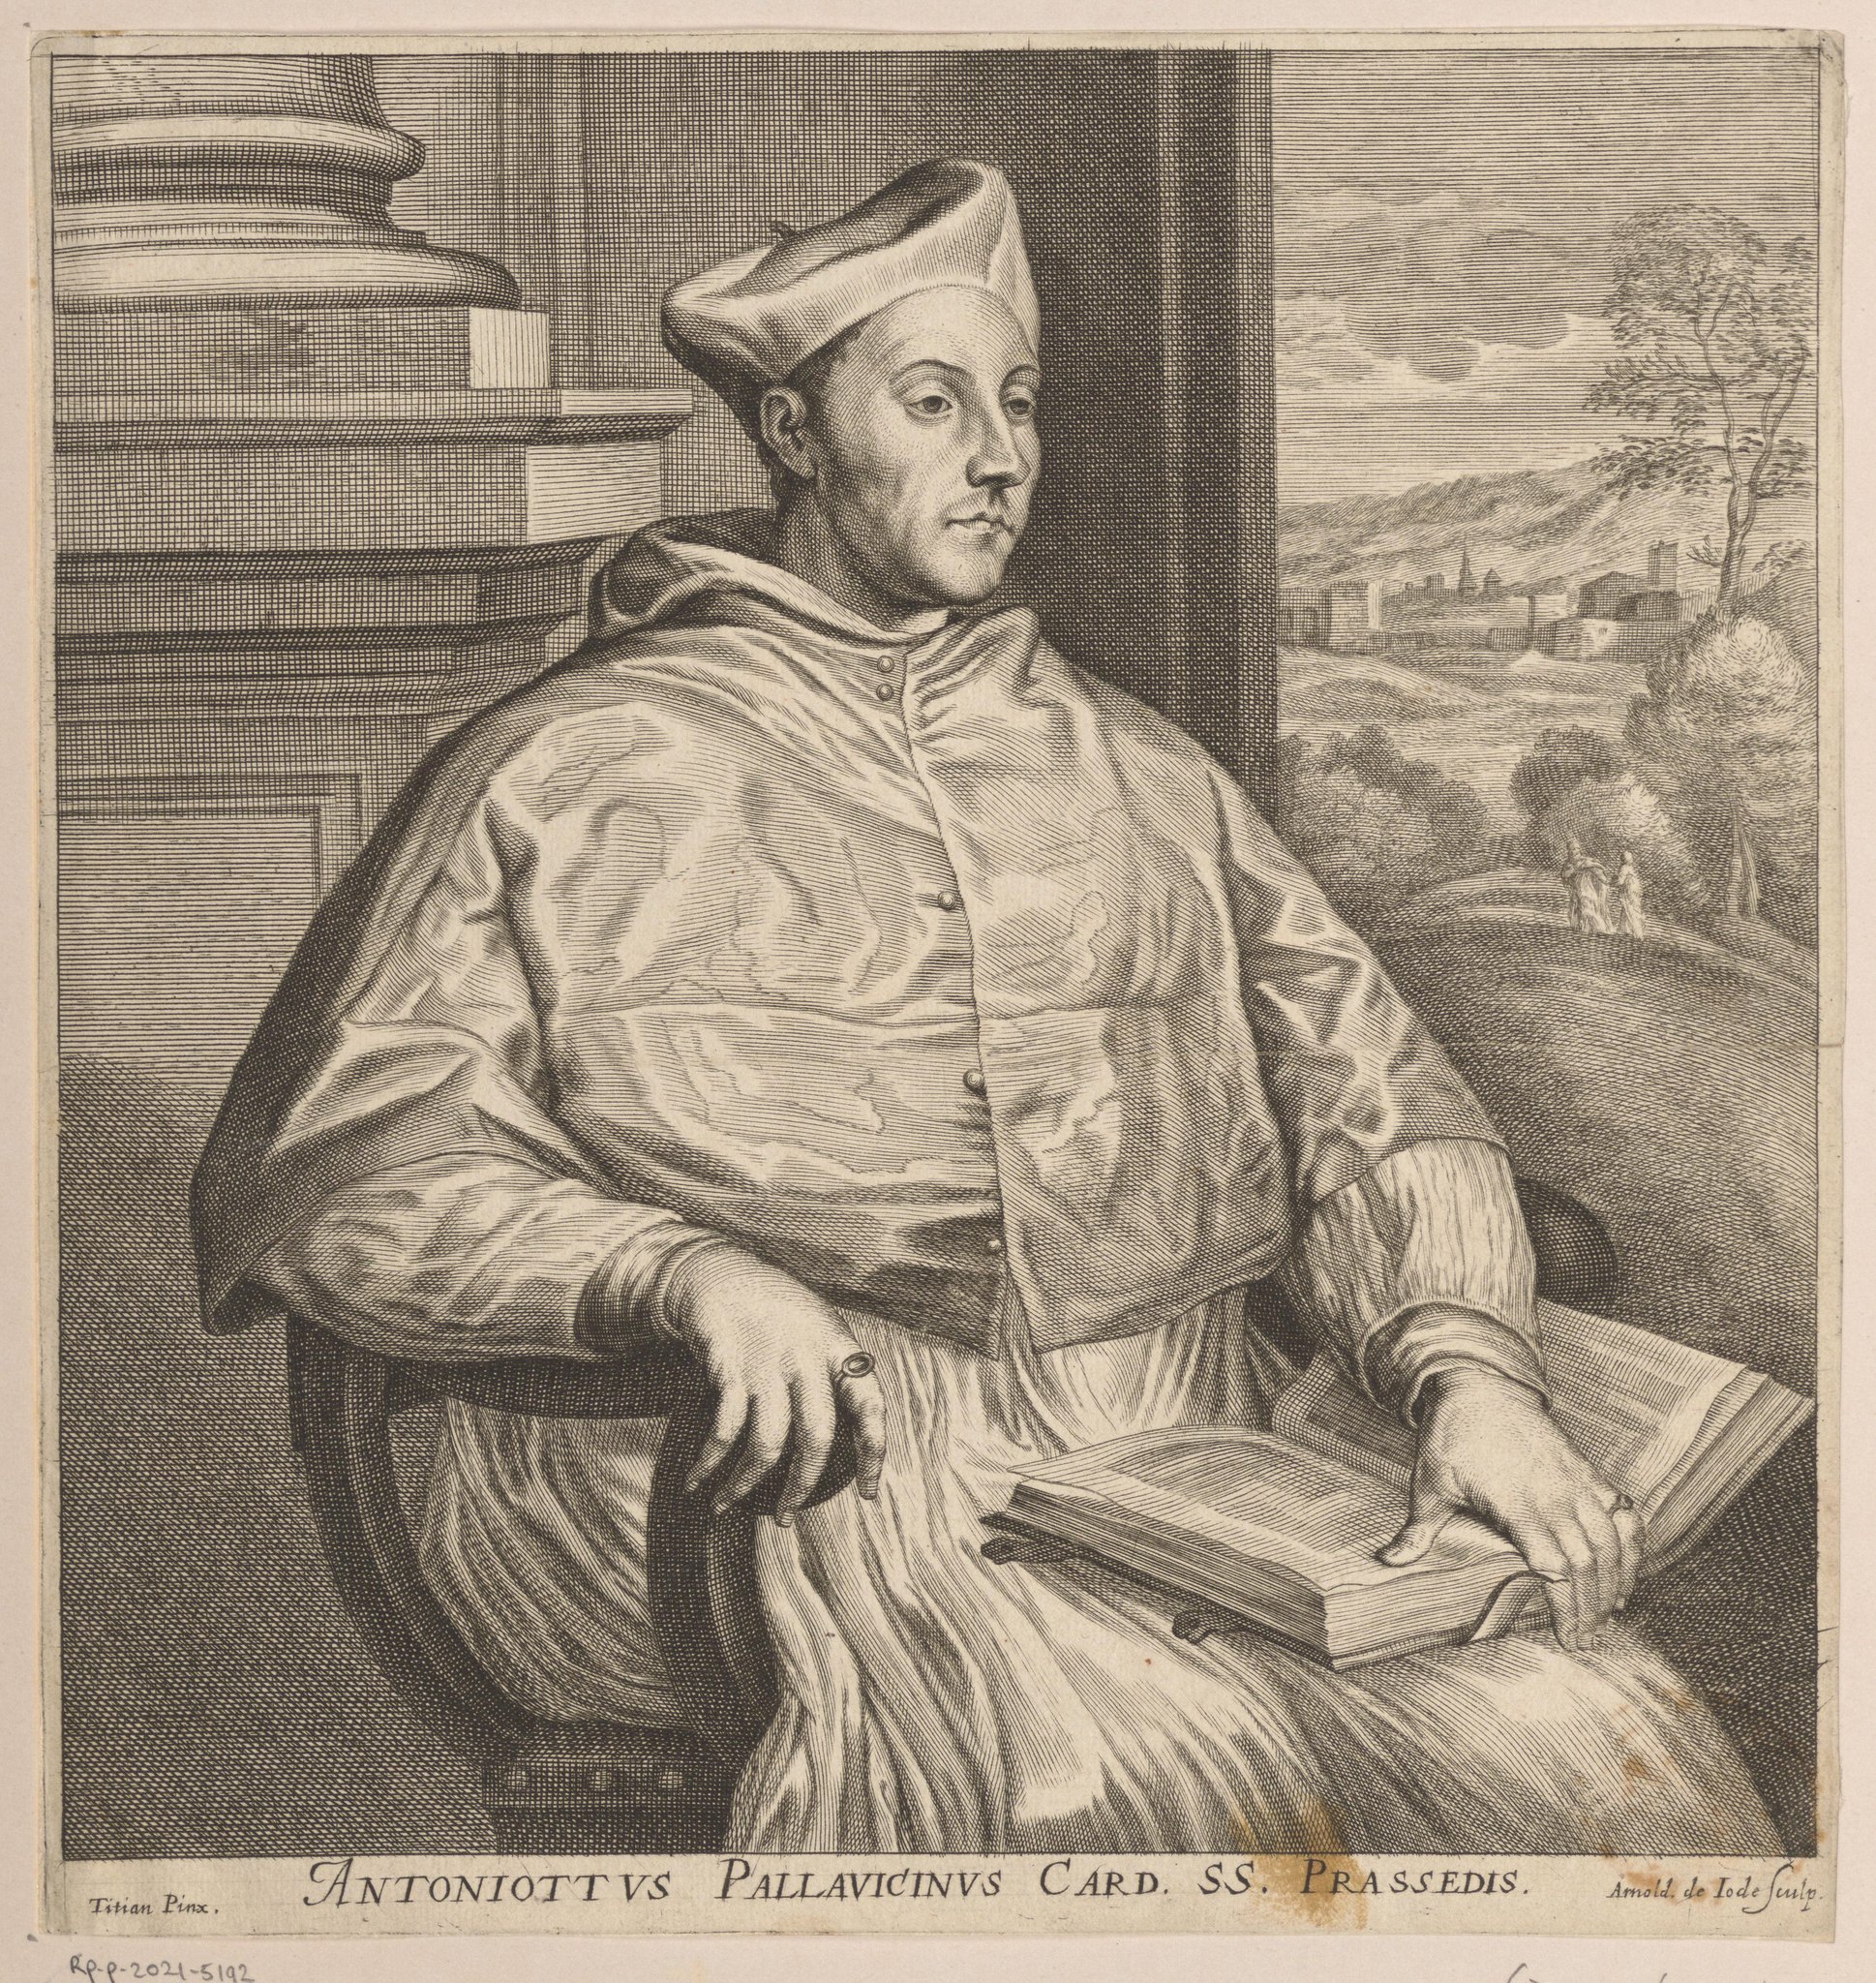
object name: print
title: Portret van Antonio Pallavicini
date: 1658-1666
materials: paper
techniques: engraving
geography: antwerp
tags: cardinal, historical persons, book - mm - book open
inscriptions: collector's mark: Lugt 240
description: Portret van Antonio Pallavicini, kardinaal, zittend met een boek op zijn schoot. Op de achtergrond een landschap met twee figuren. In de marge de naam en functie van de geportretteerde in het Latijn.